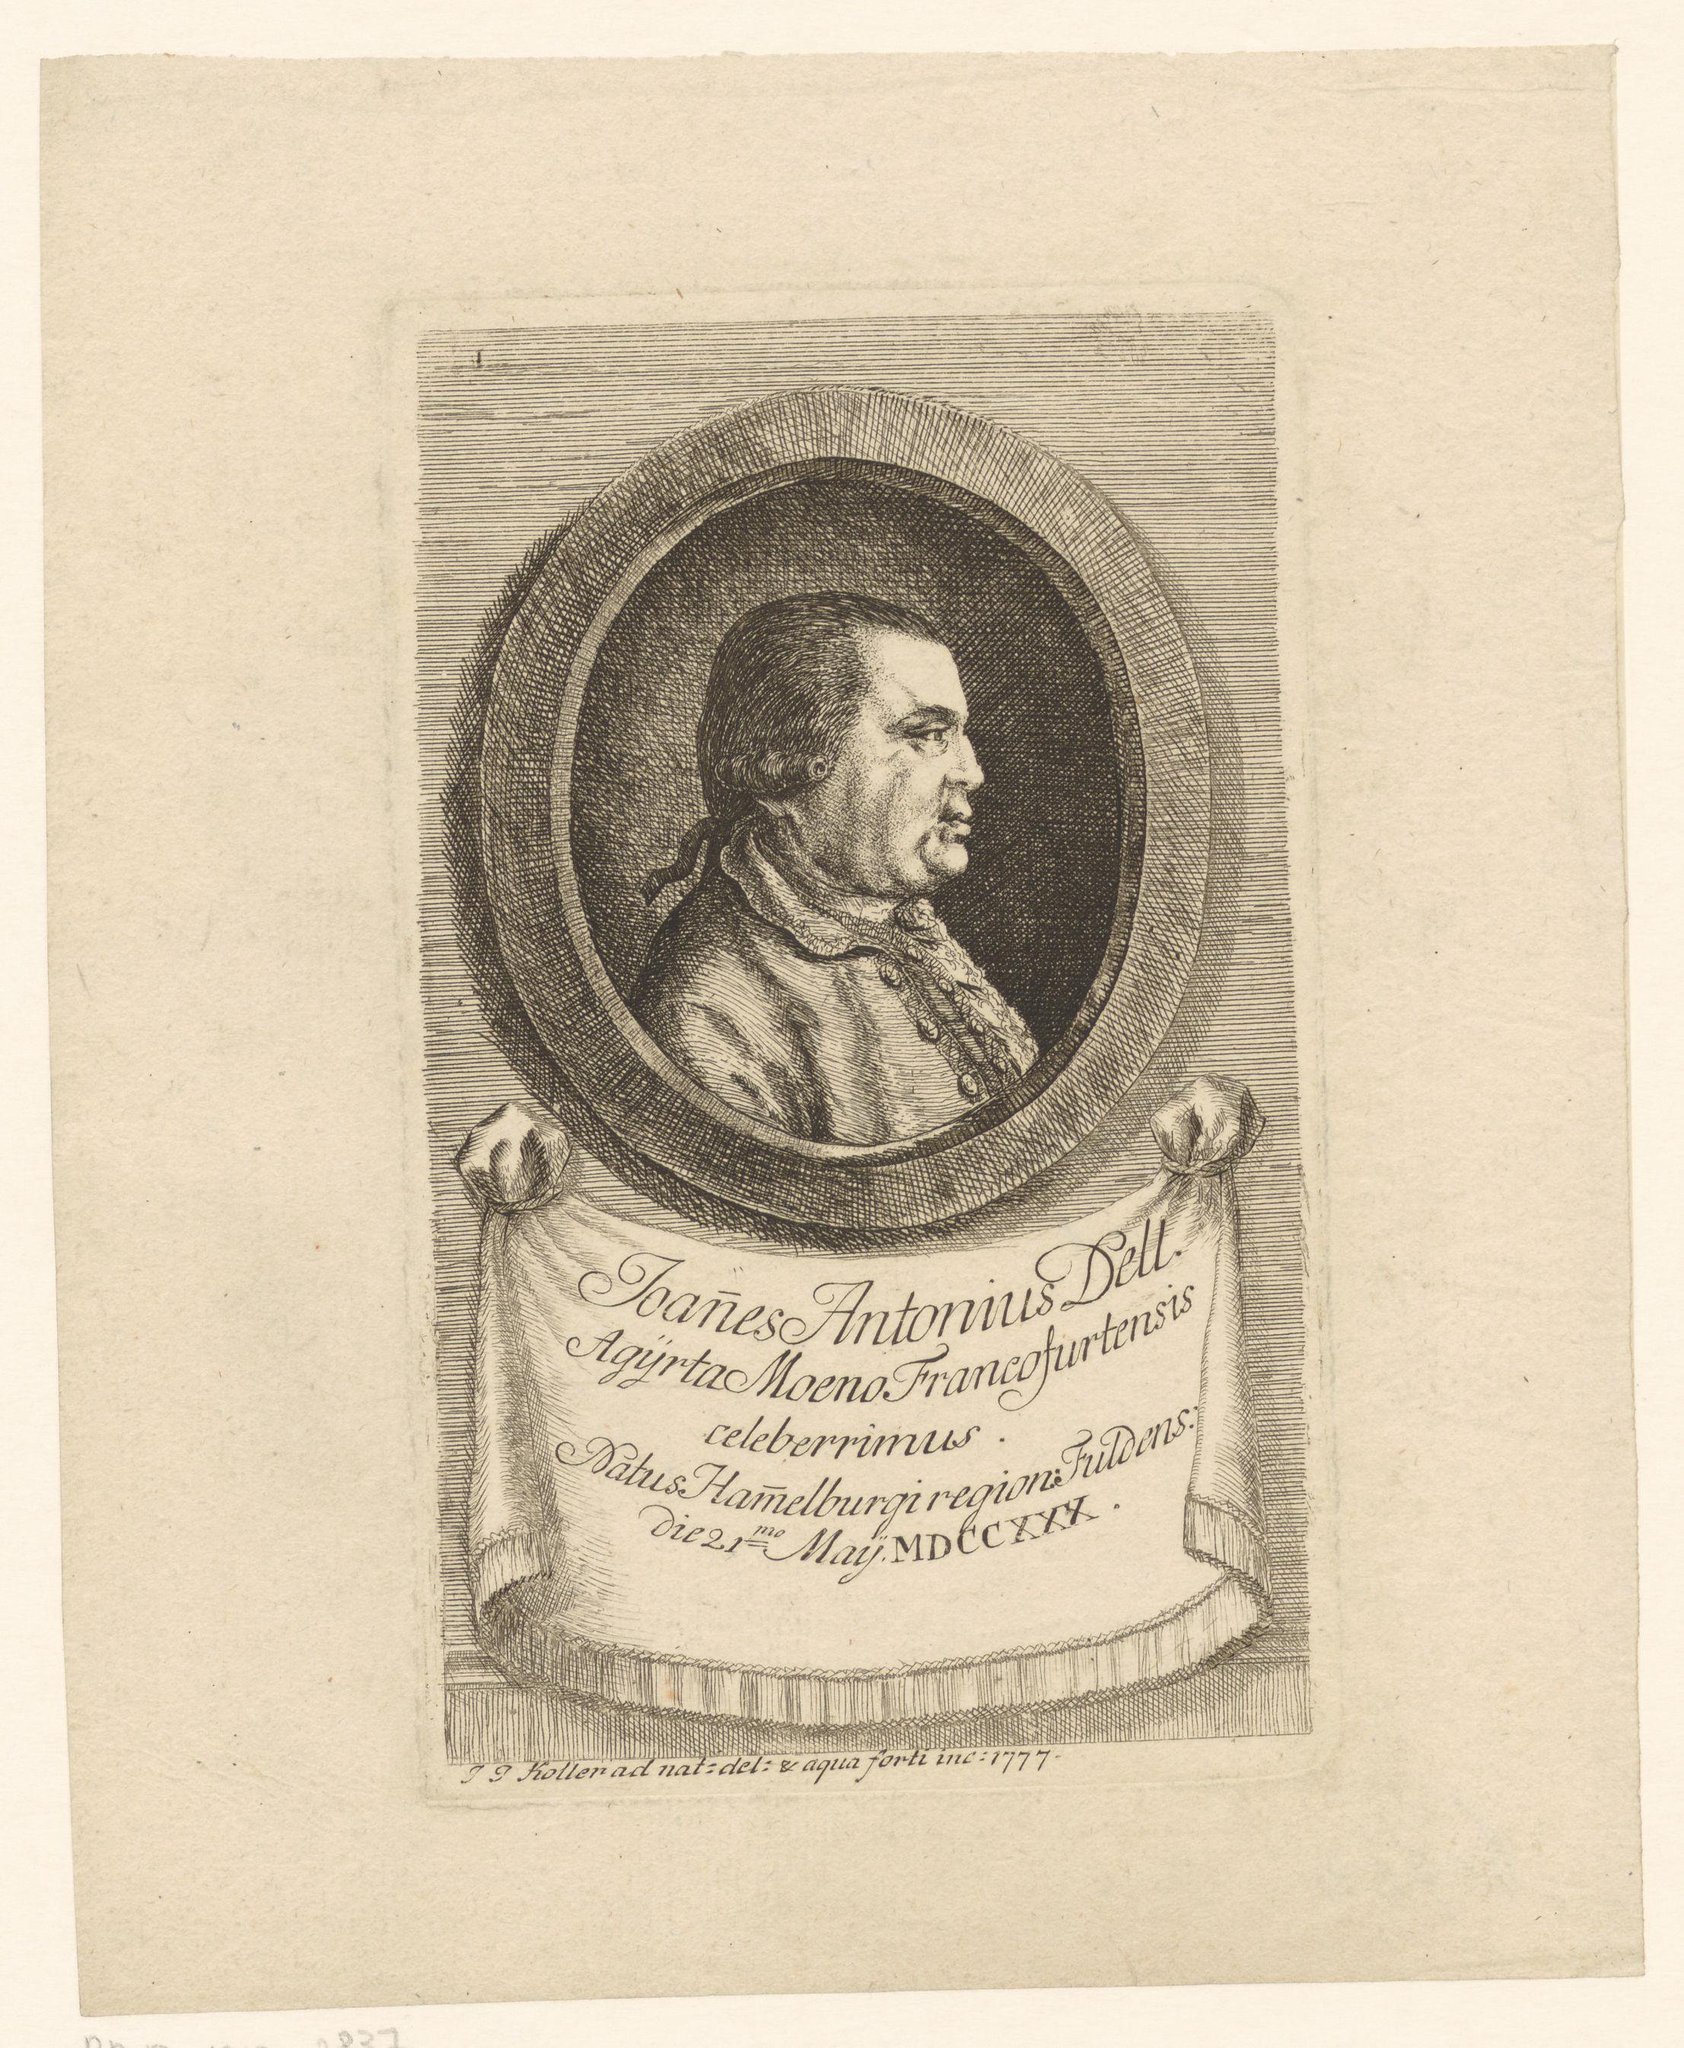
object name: print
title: Portret van Johann Anton Dell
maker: johann jakob koller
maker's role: print maker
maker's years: 1746-1805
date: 1777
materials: paper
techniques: etching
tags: print maker, quack, charlatan, mountebank, 'saltimbanco' (+ portrait of scholar, scientist), historical persons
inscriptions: collector's mark: Lugt 2228